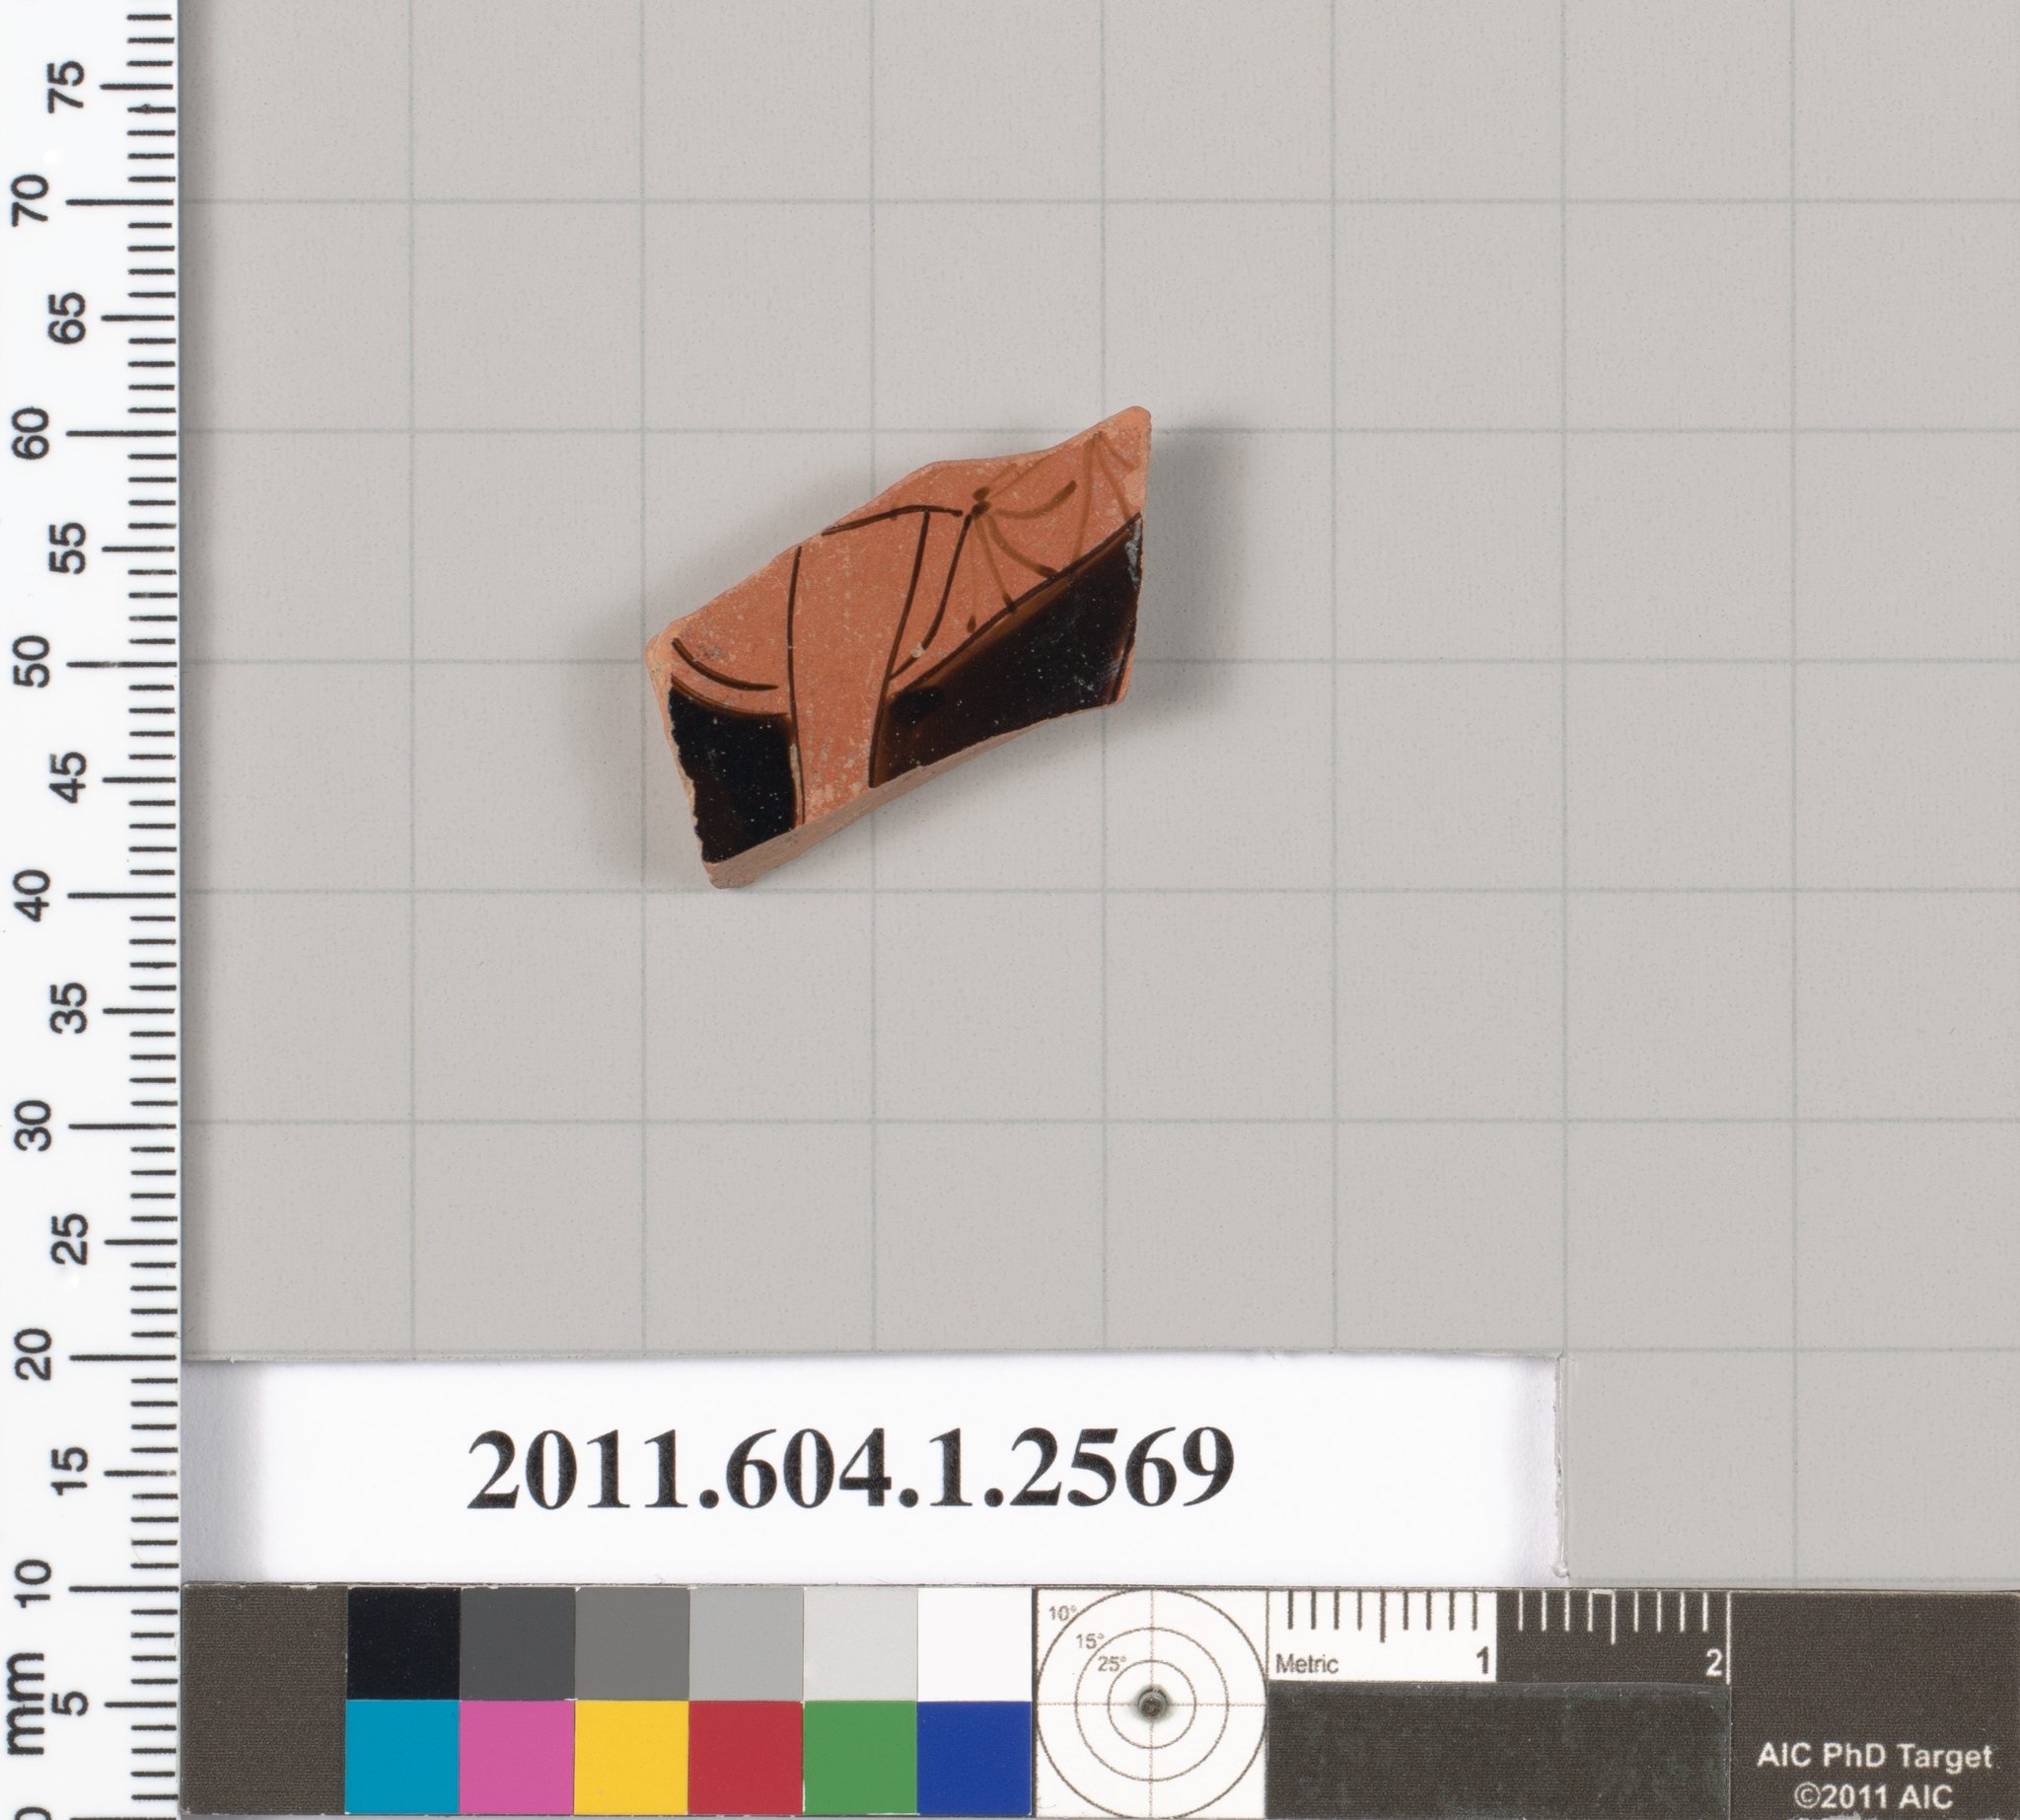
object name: kylix fragment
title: Terracotta fragment of a kylix (drinking cup)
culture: greek, attic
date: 490-480 BCE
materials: terracotta